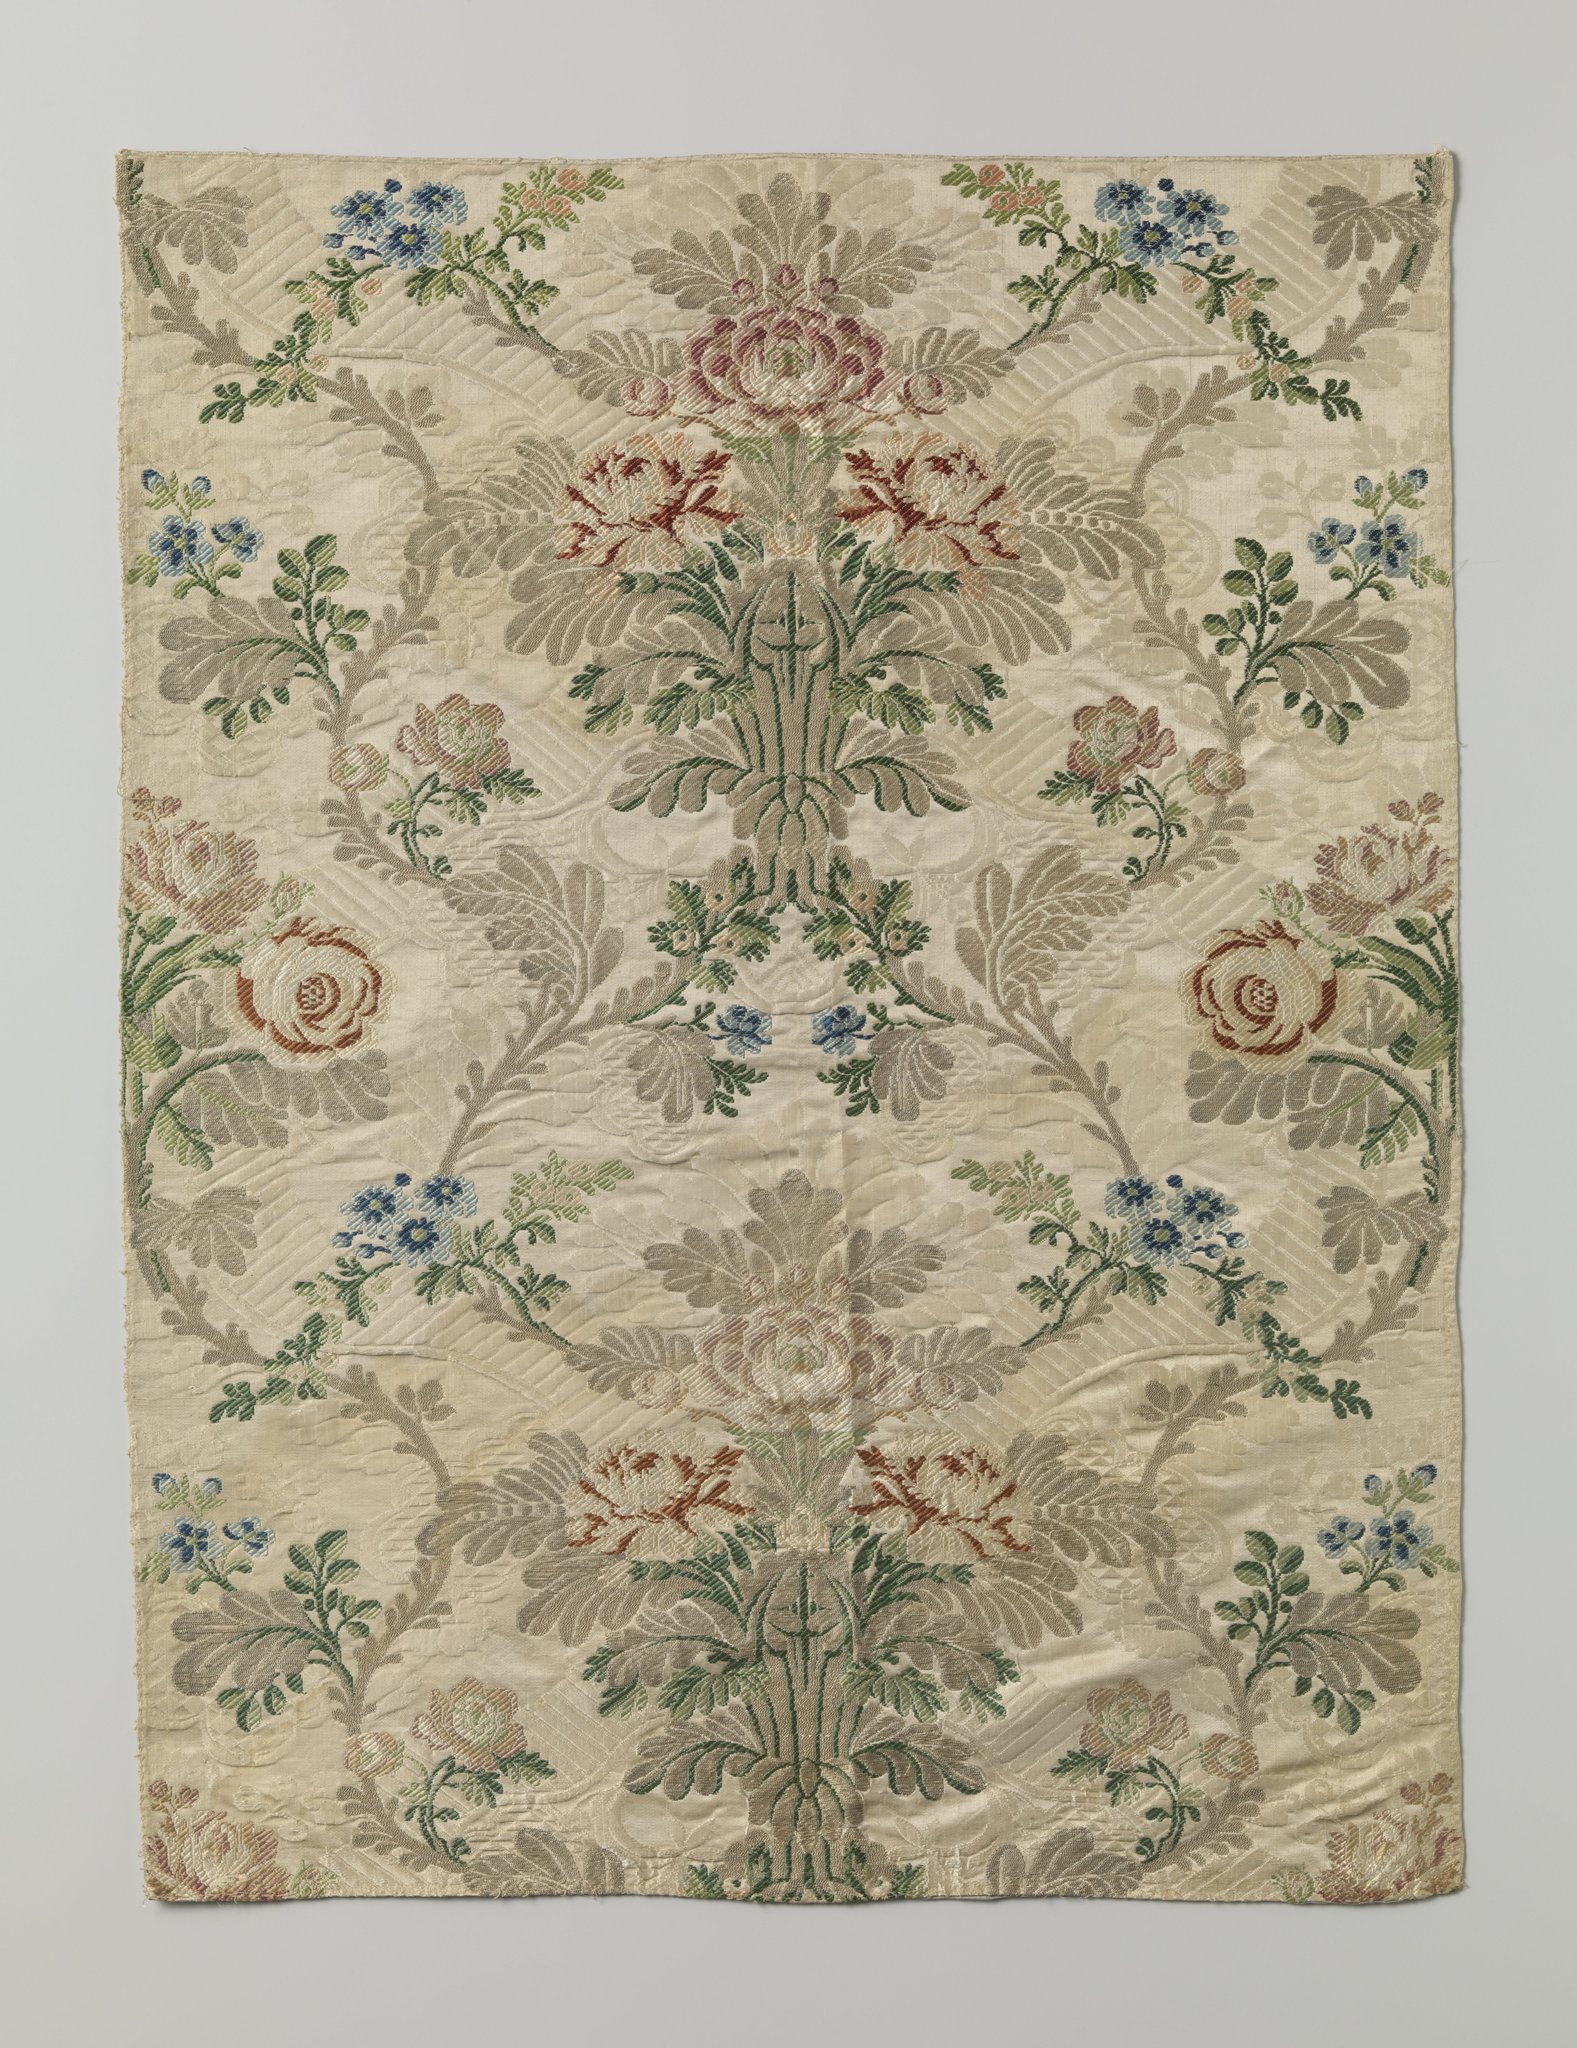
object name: fragment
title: Fragment veelkleurige gebrocheerde zijde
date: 1700-1800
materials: silk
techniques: brocade, damask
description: Fragment veelkleurig zijdeweefsel. De beige grond heeft een veelkleurige patroon van een vaasachtig ornament waaruit bladeren en bloemen komen, verbonden door slingerende bloemtakken en bloem- en bladranken. Gevoerd met zijde.